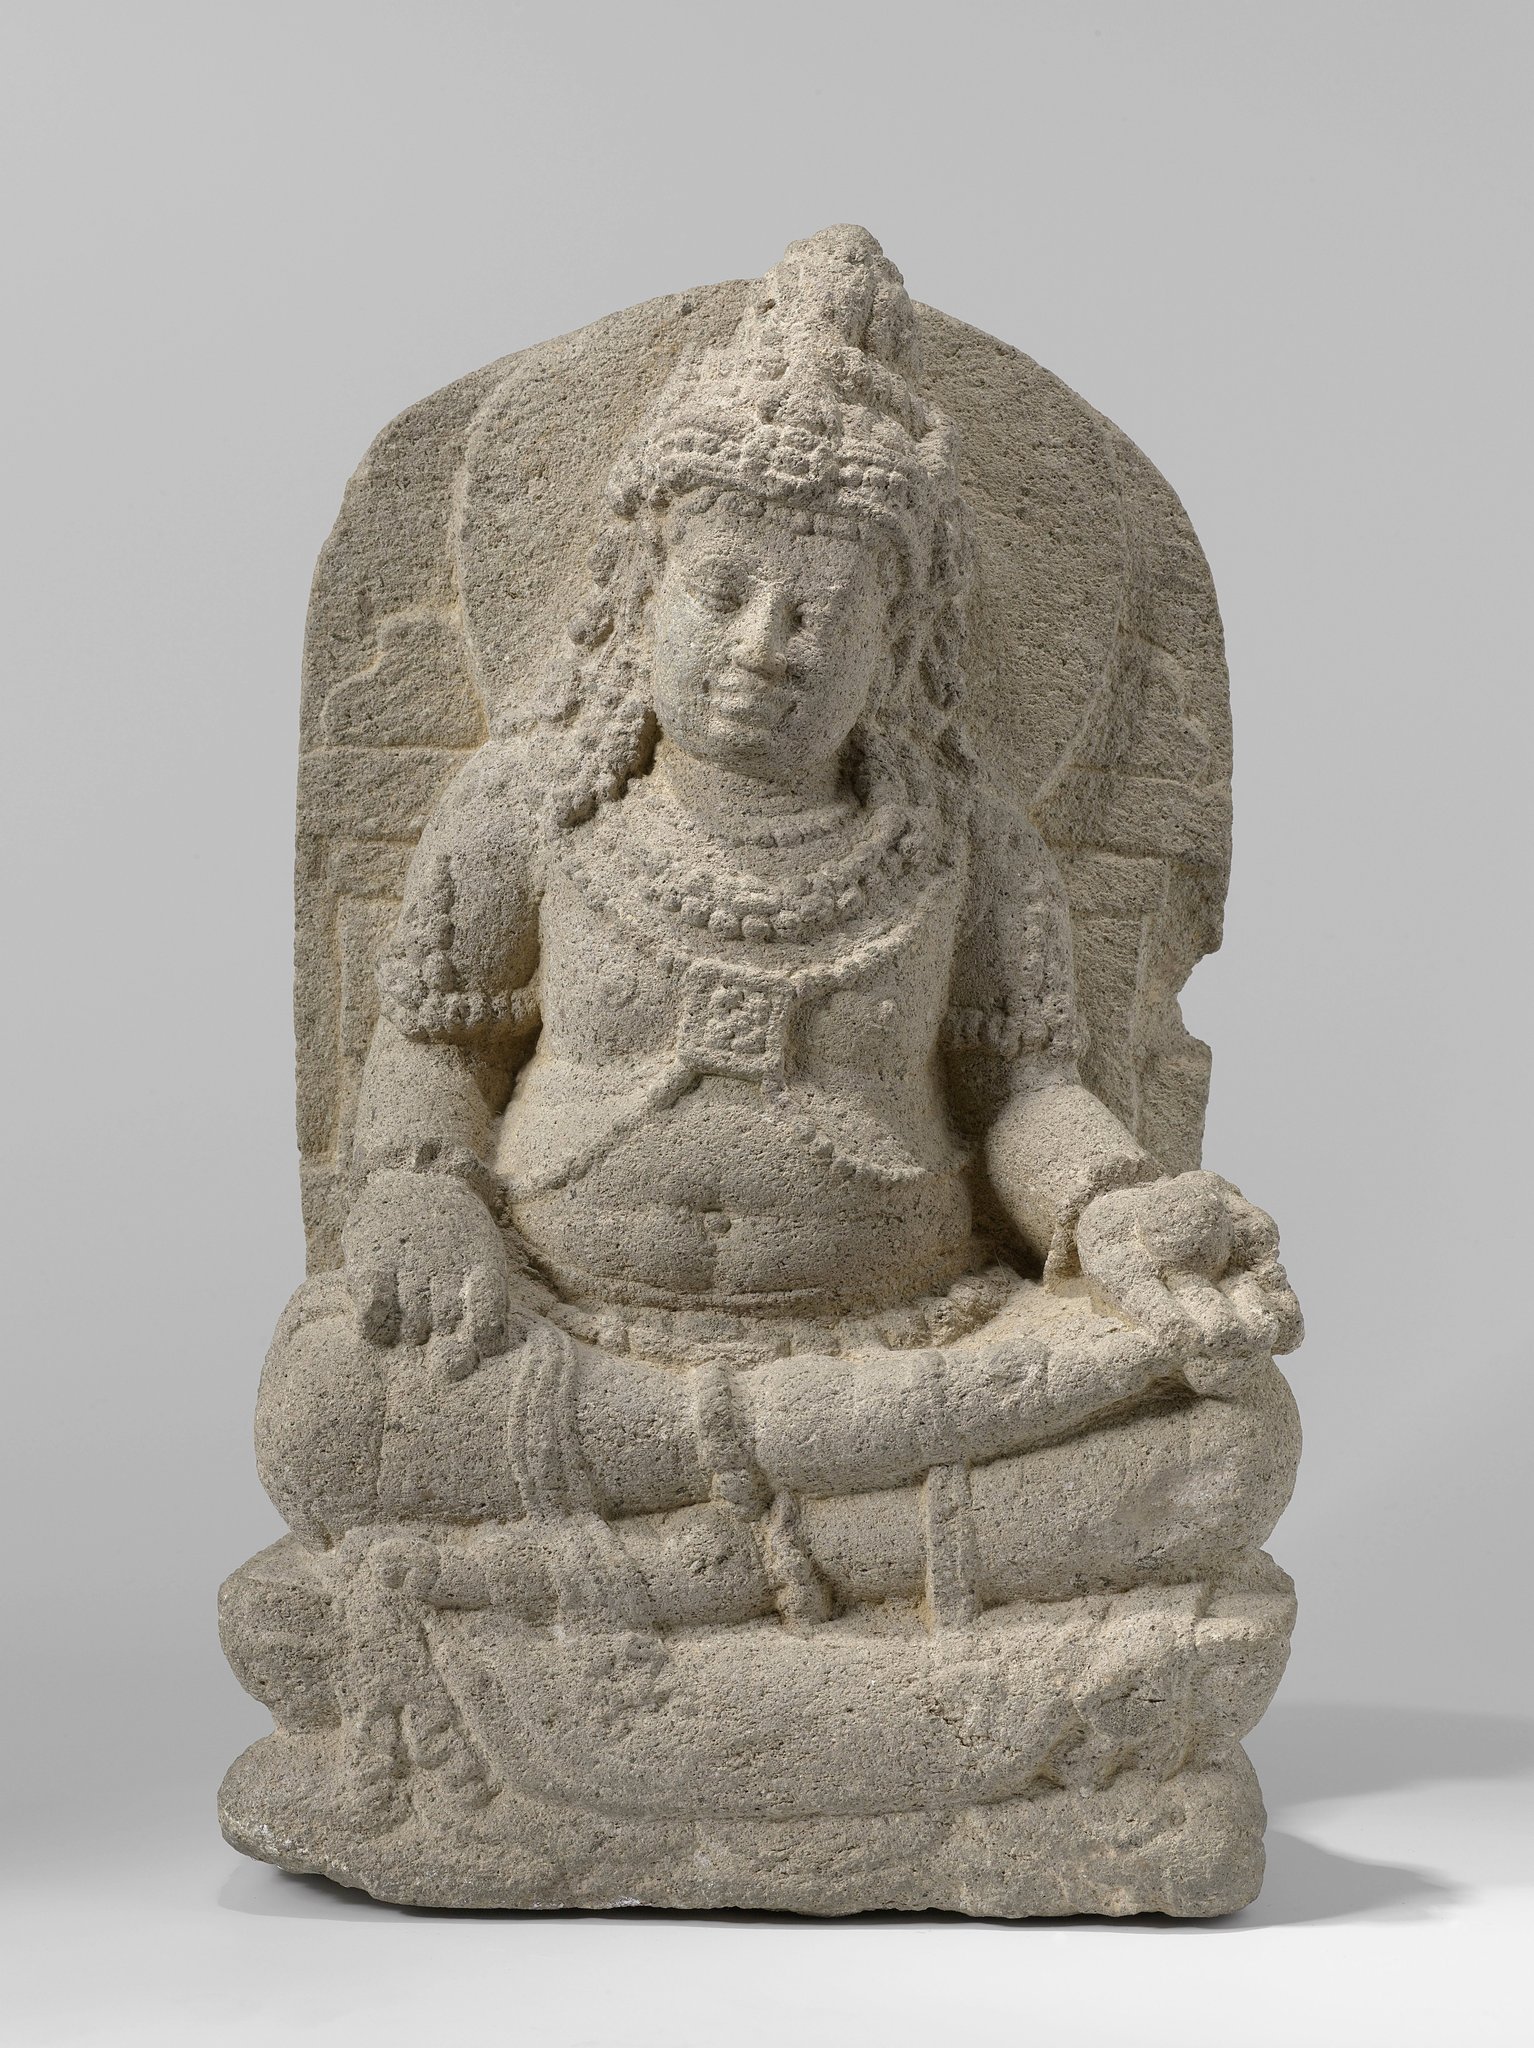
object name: figure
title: Beeld van de rijkdomsgod Kubera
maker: Anonymous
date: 775-825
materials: stone, rock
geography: gedong songo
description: Kuvera. Indonesia, Central Java, Gedong Songo. Late 8th - early 9th century. Volcanic rock (andesite). The god of wealth is recognisable by the jewel and his bulging purse. The crossed bead string over his chest is worn only by young deities. This statue originated from the lowest temple of the Gedong Songo temple complex built against the slopes of Ungaran mountain. All these temples are dedicated to Shiva. These represent some of the earliest antiquities of the Central Javanese period (late 8th - early 10th century).